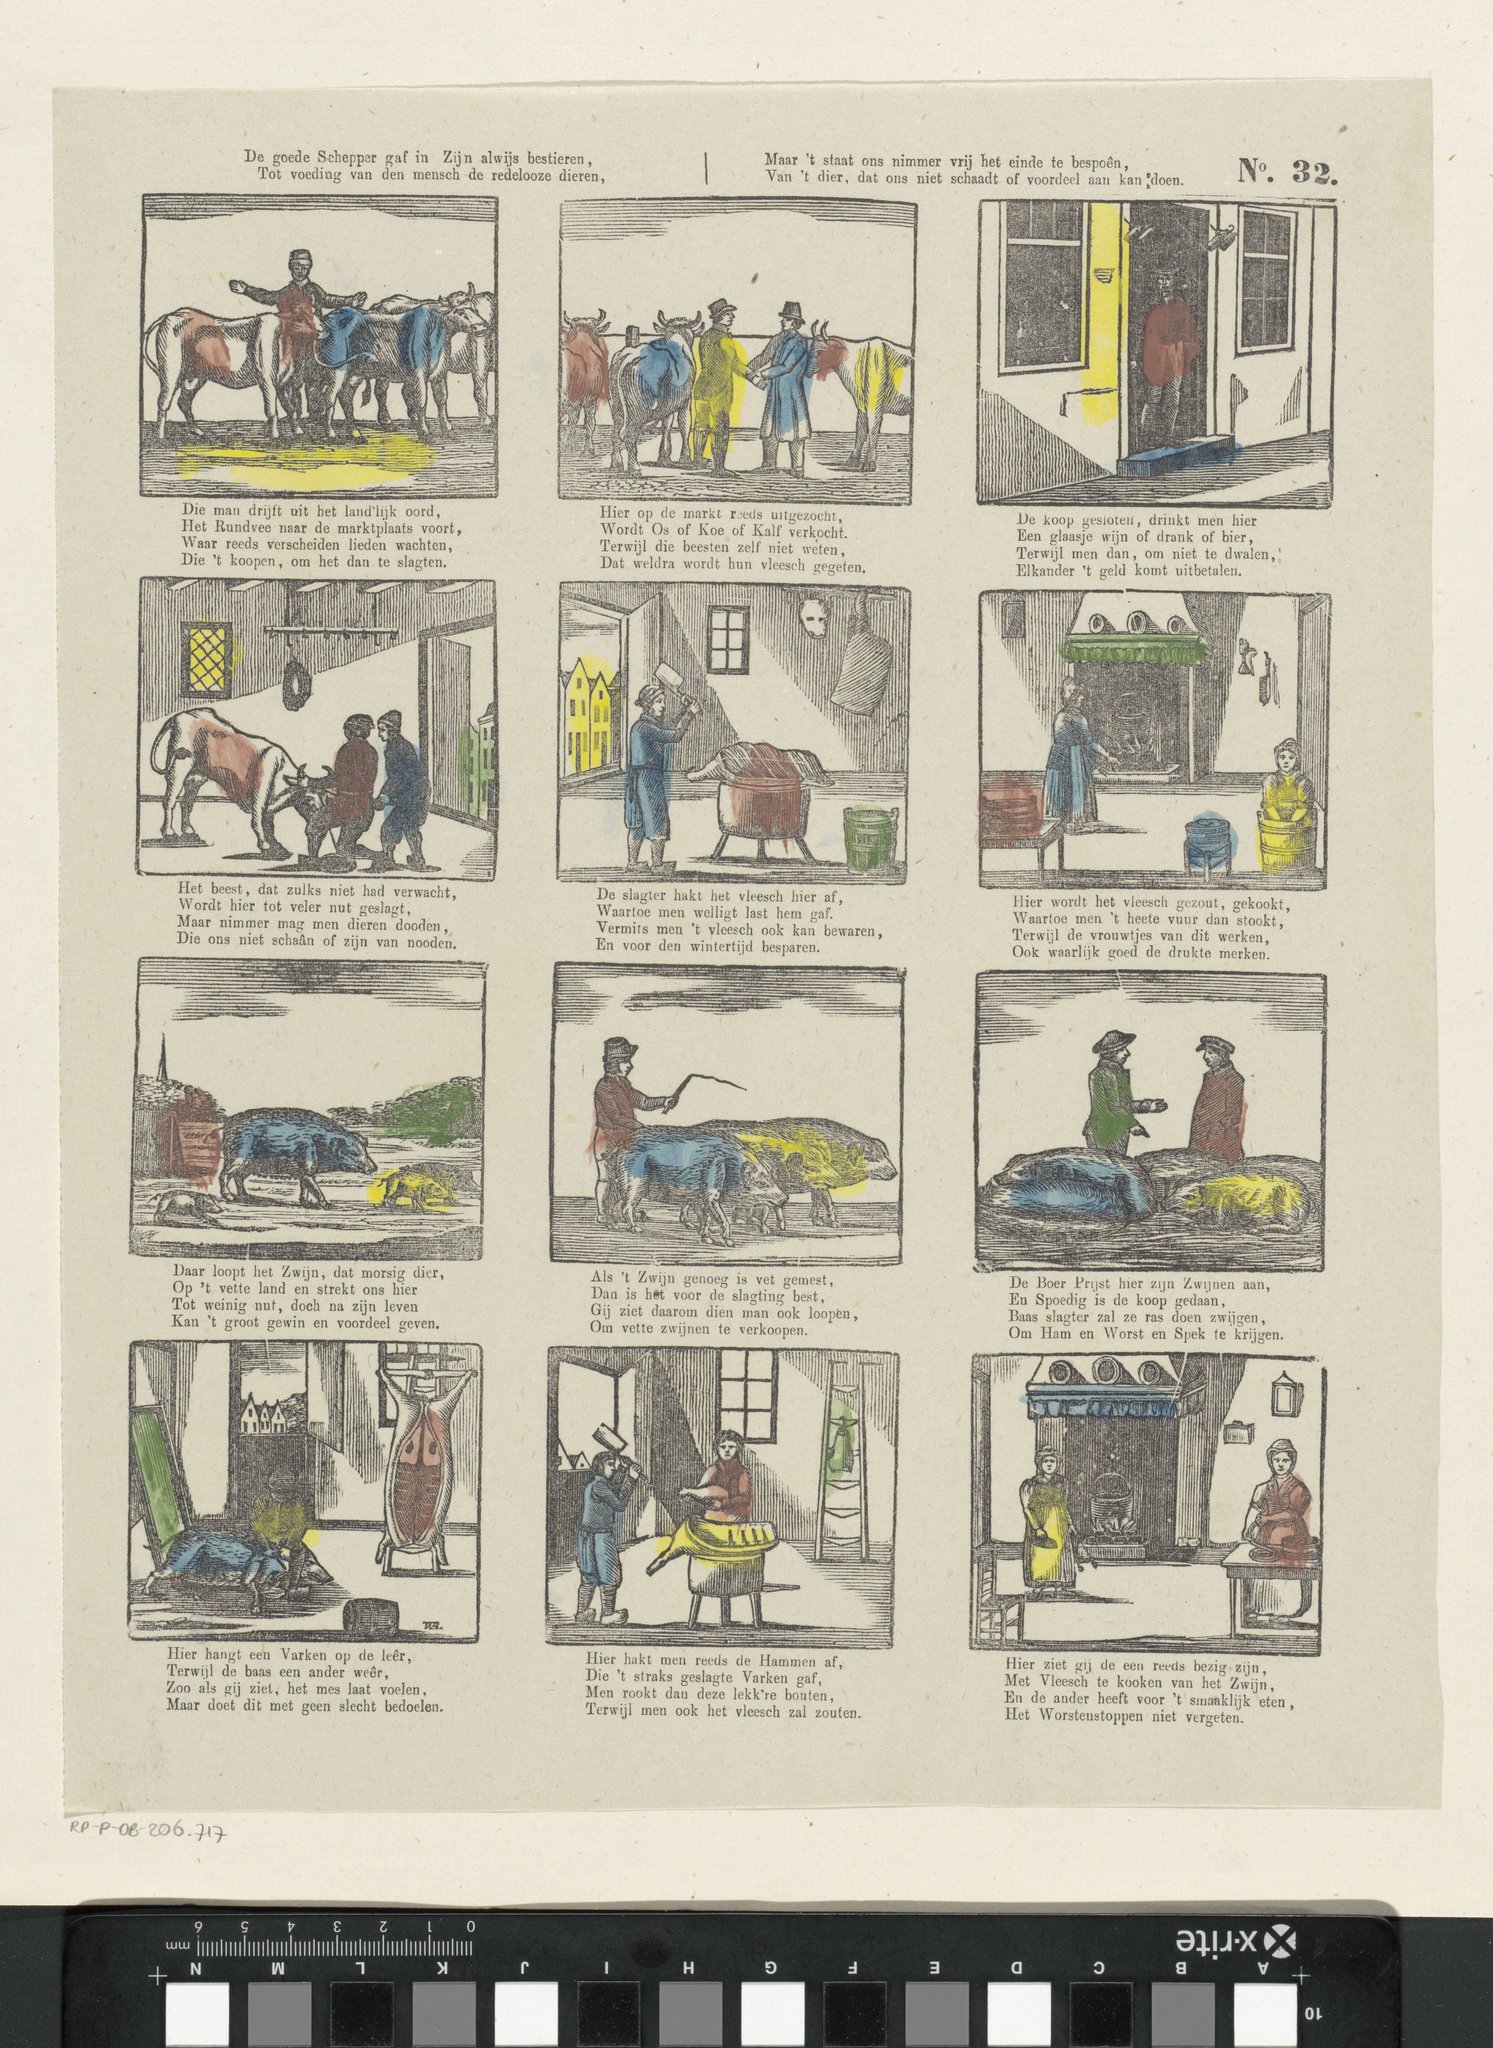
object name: print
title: De goede schepper gaf in zijn alwijs bestieren, / Tot voeding van den mensch de redelooze dieren, / Maar 't staat ons nimmer vrij het einde te bespoên / Van 't dier, dat ons niet schaadt of voordeel aan kan doen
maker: willem bal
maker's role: print maker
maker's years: 1808-1897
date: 1850-1870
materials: paper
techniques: colour, letterpress printing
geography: netherlands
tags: pig, cow, slaughtered ox or pig, butcher, slaughterman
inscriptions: collector's mark: Lugt 2760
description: Blad met 12 voorstellingen van het fokken, slachten en bereiden van koeien en varkens. Onder elke afbeelding een vierregelig vers. Rechtsboven genummerd: No. 32.